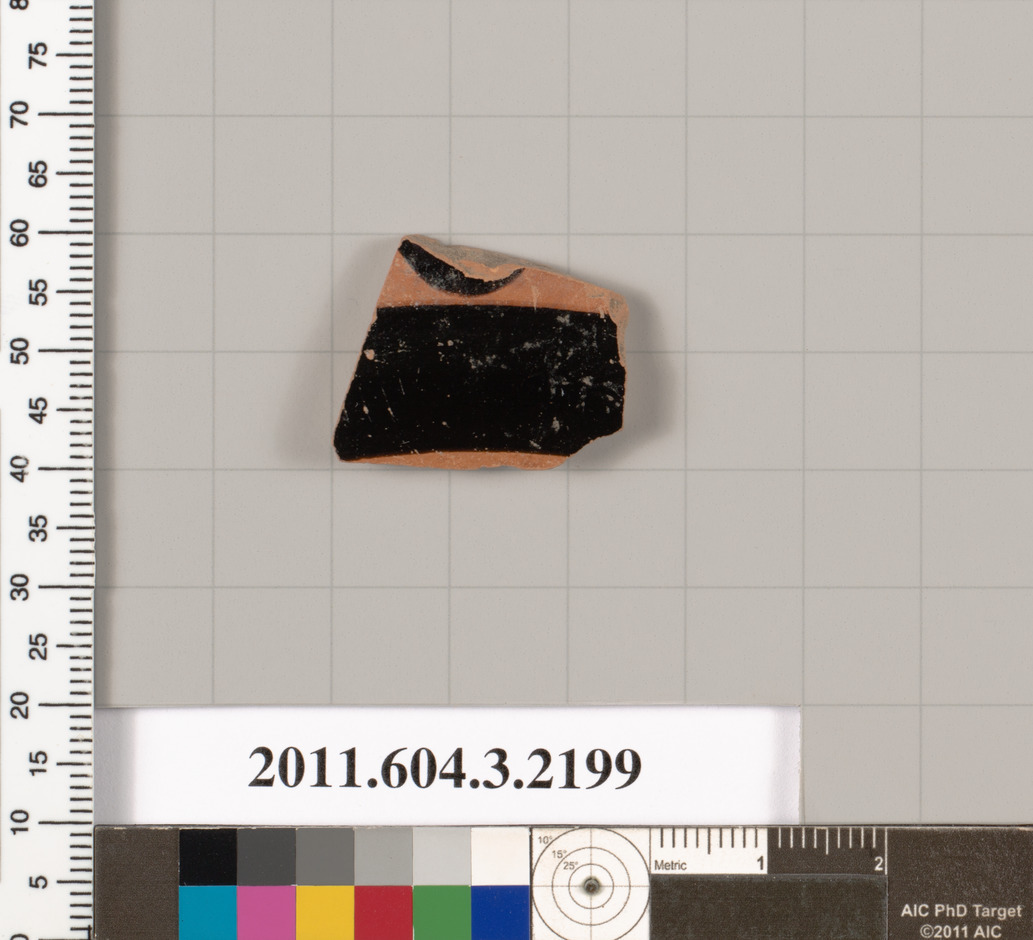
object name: kylix fragment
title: Terracotta fragment of a kylix (drinking cup)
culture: greek, attic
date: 600-401 BCE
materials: terracotta